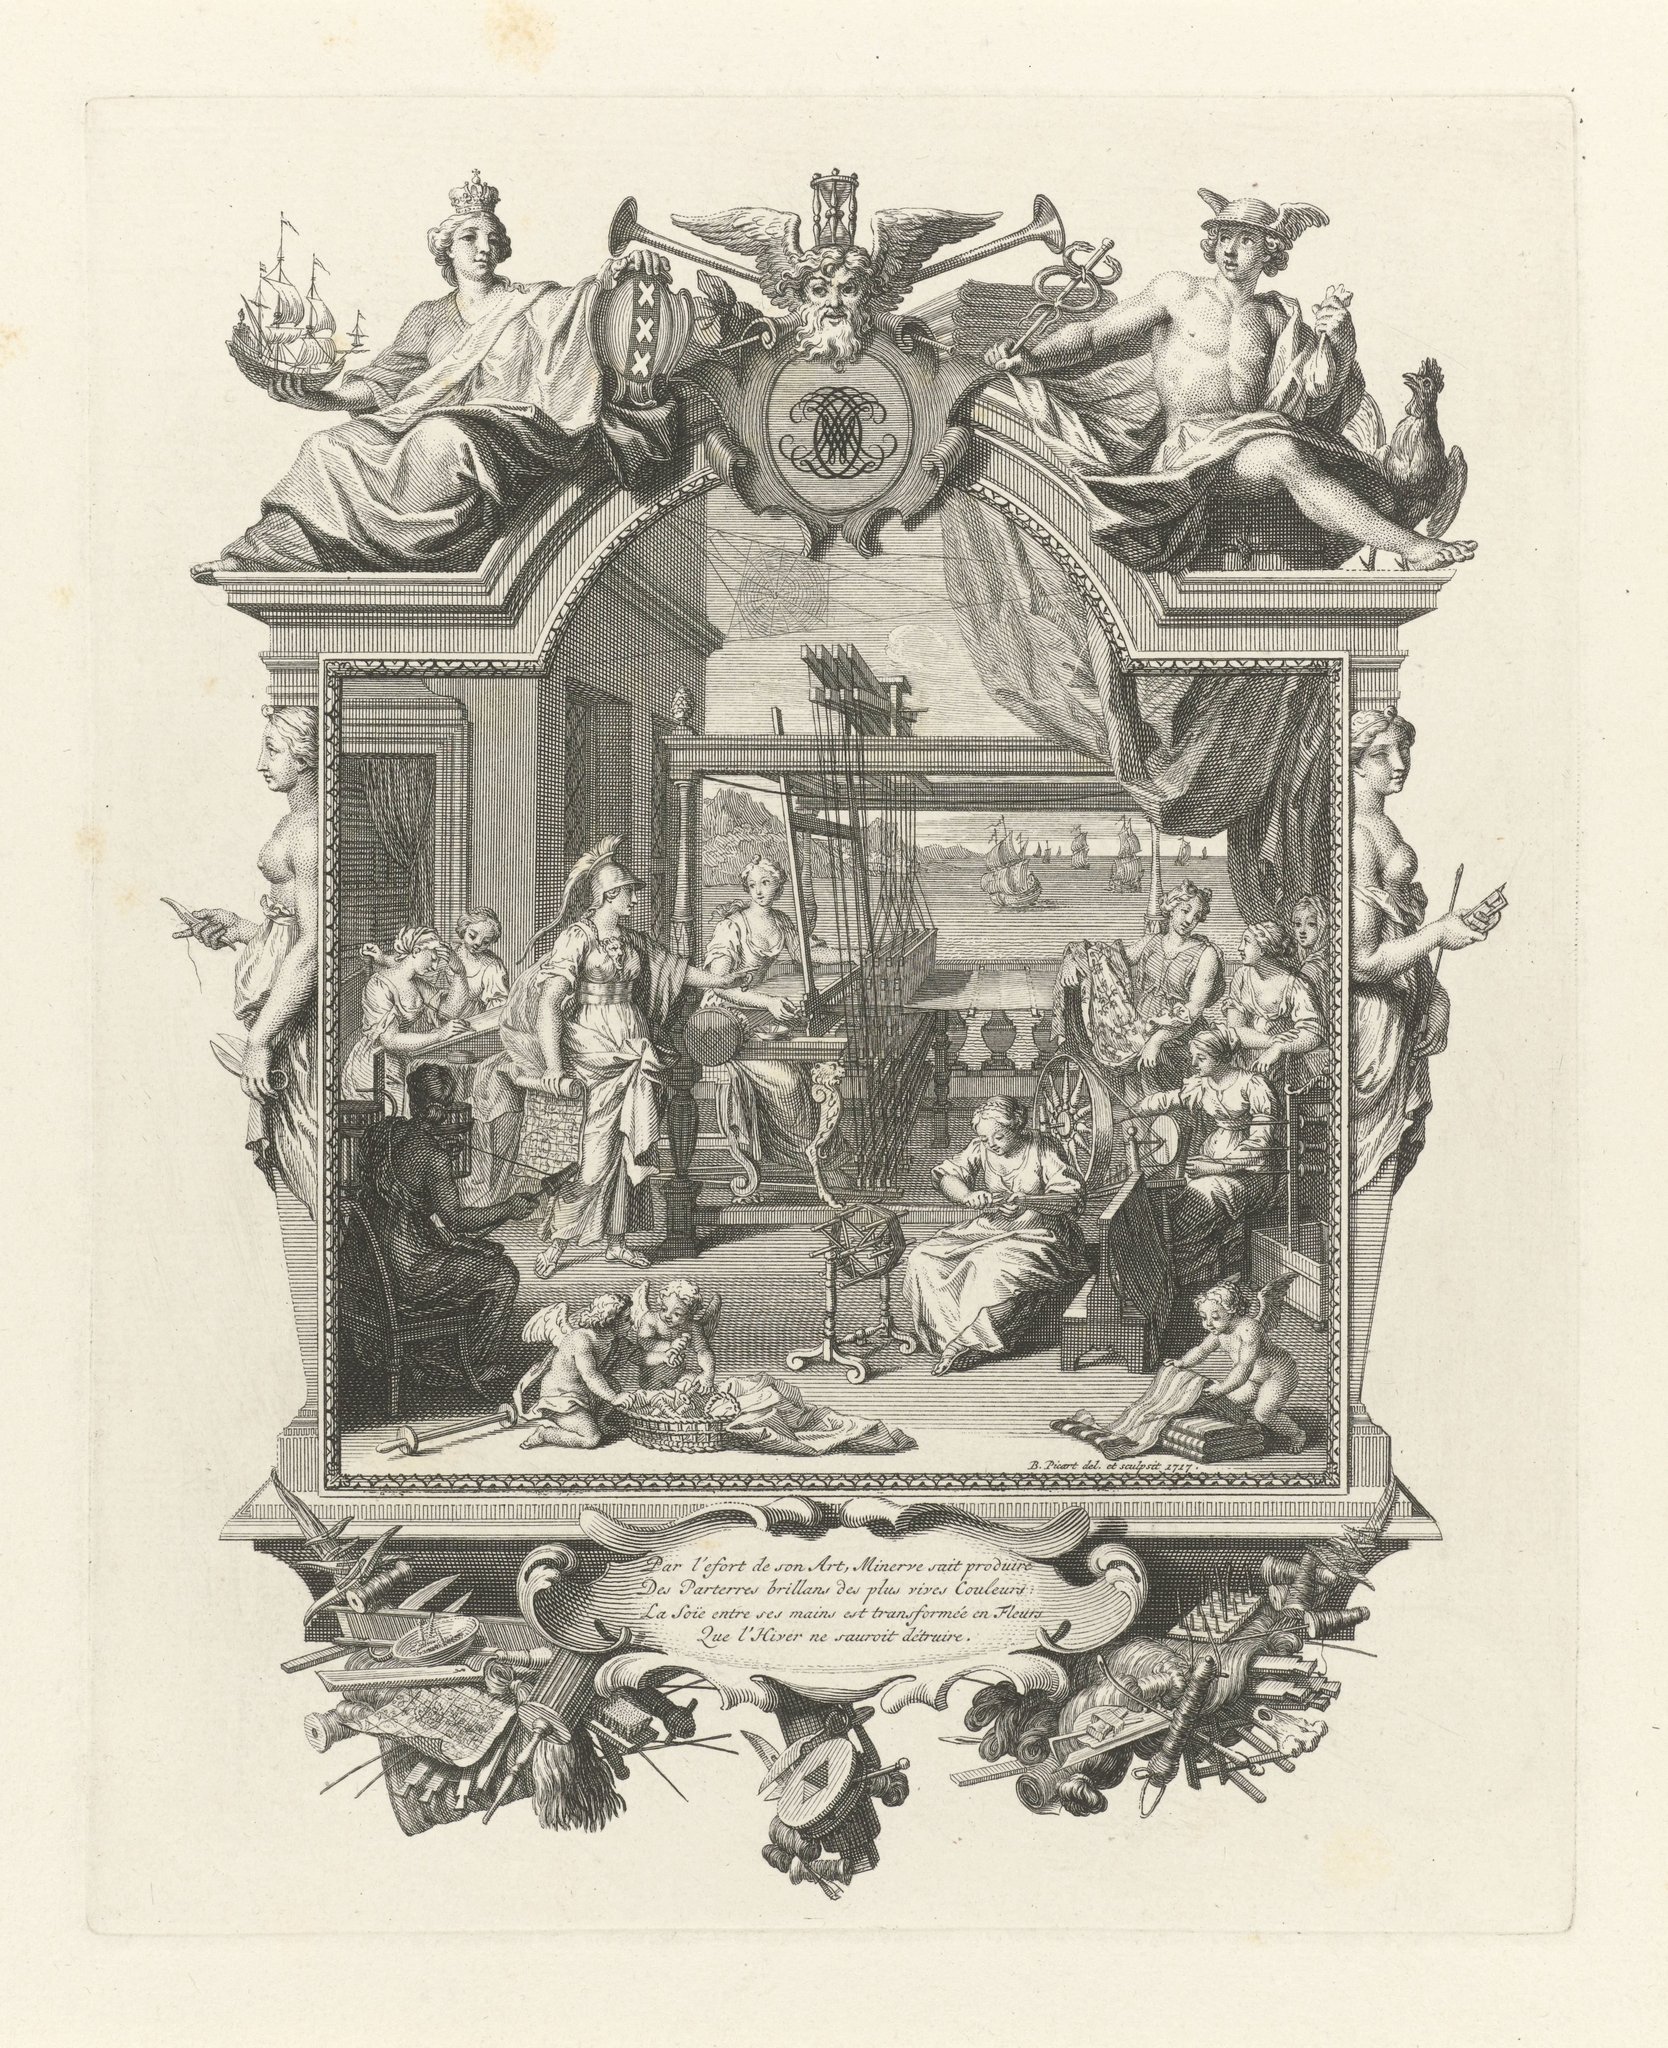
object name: print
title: Minerva bezoekt vrouwen die spinnen en weven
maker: bernard picart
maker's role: draughtsman, print maker, publisher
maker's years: 1673-1733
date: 1717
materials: paper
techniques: engraving, etching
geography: amsterdam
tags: arachne changed into a spider: when hanging herself after having been defeated in a weaving contest with minerva, arachne is changed into a spider by the goddess (ovid, metamorphoses vi 135), (story of) minerva (pallas, athena), (story of) mercury (hermes), weaving, father time, man with wings and scythe, spinning (manufacture of yarn), 'navigatione' (ripa)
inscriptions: collector's mark: Lugt 240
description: Minerva bezoekt vrouwen die wol spinnen en stof weven. Ze houdt een weefpatroon in de hand en wijst op vrouwen die de stof bekijken. Boven het weefgetouw een spinnenweb, als verwijzing naar Arachne die door haar in een spin is veranderd. Op de achtergrond een gezicht op zee. De voorstelling is gevat in een uitbundig gedecoreerd cartouche dat wordt bekroond door Vader Tijd, de personificatie van Scheepvaart (met zeilschip in miniatuur) en Mercurius. Onderaan een vierregelig gedicht in het Frans.